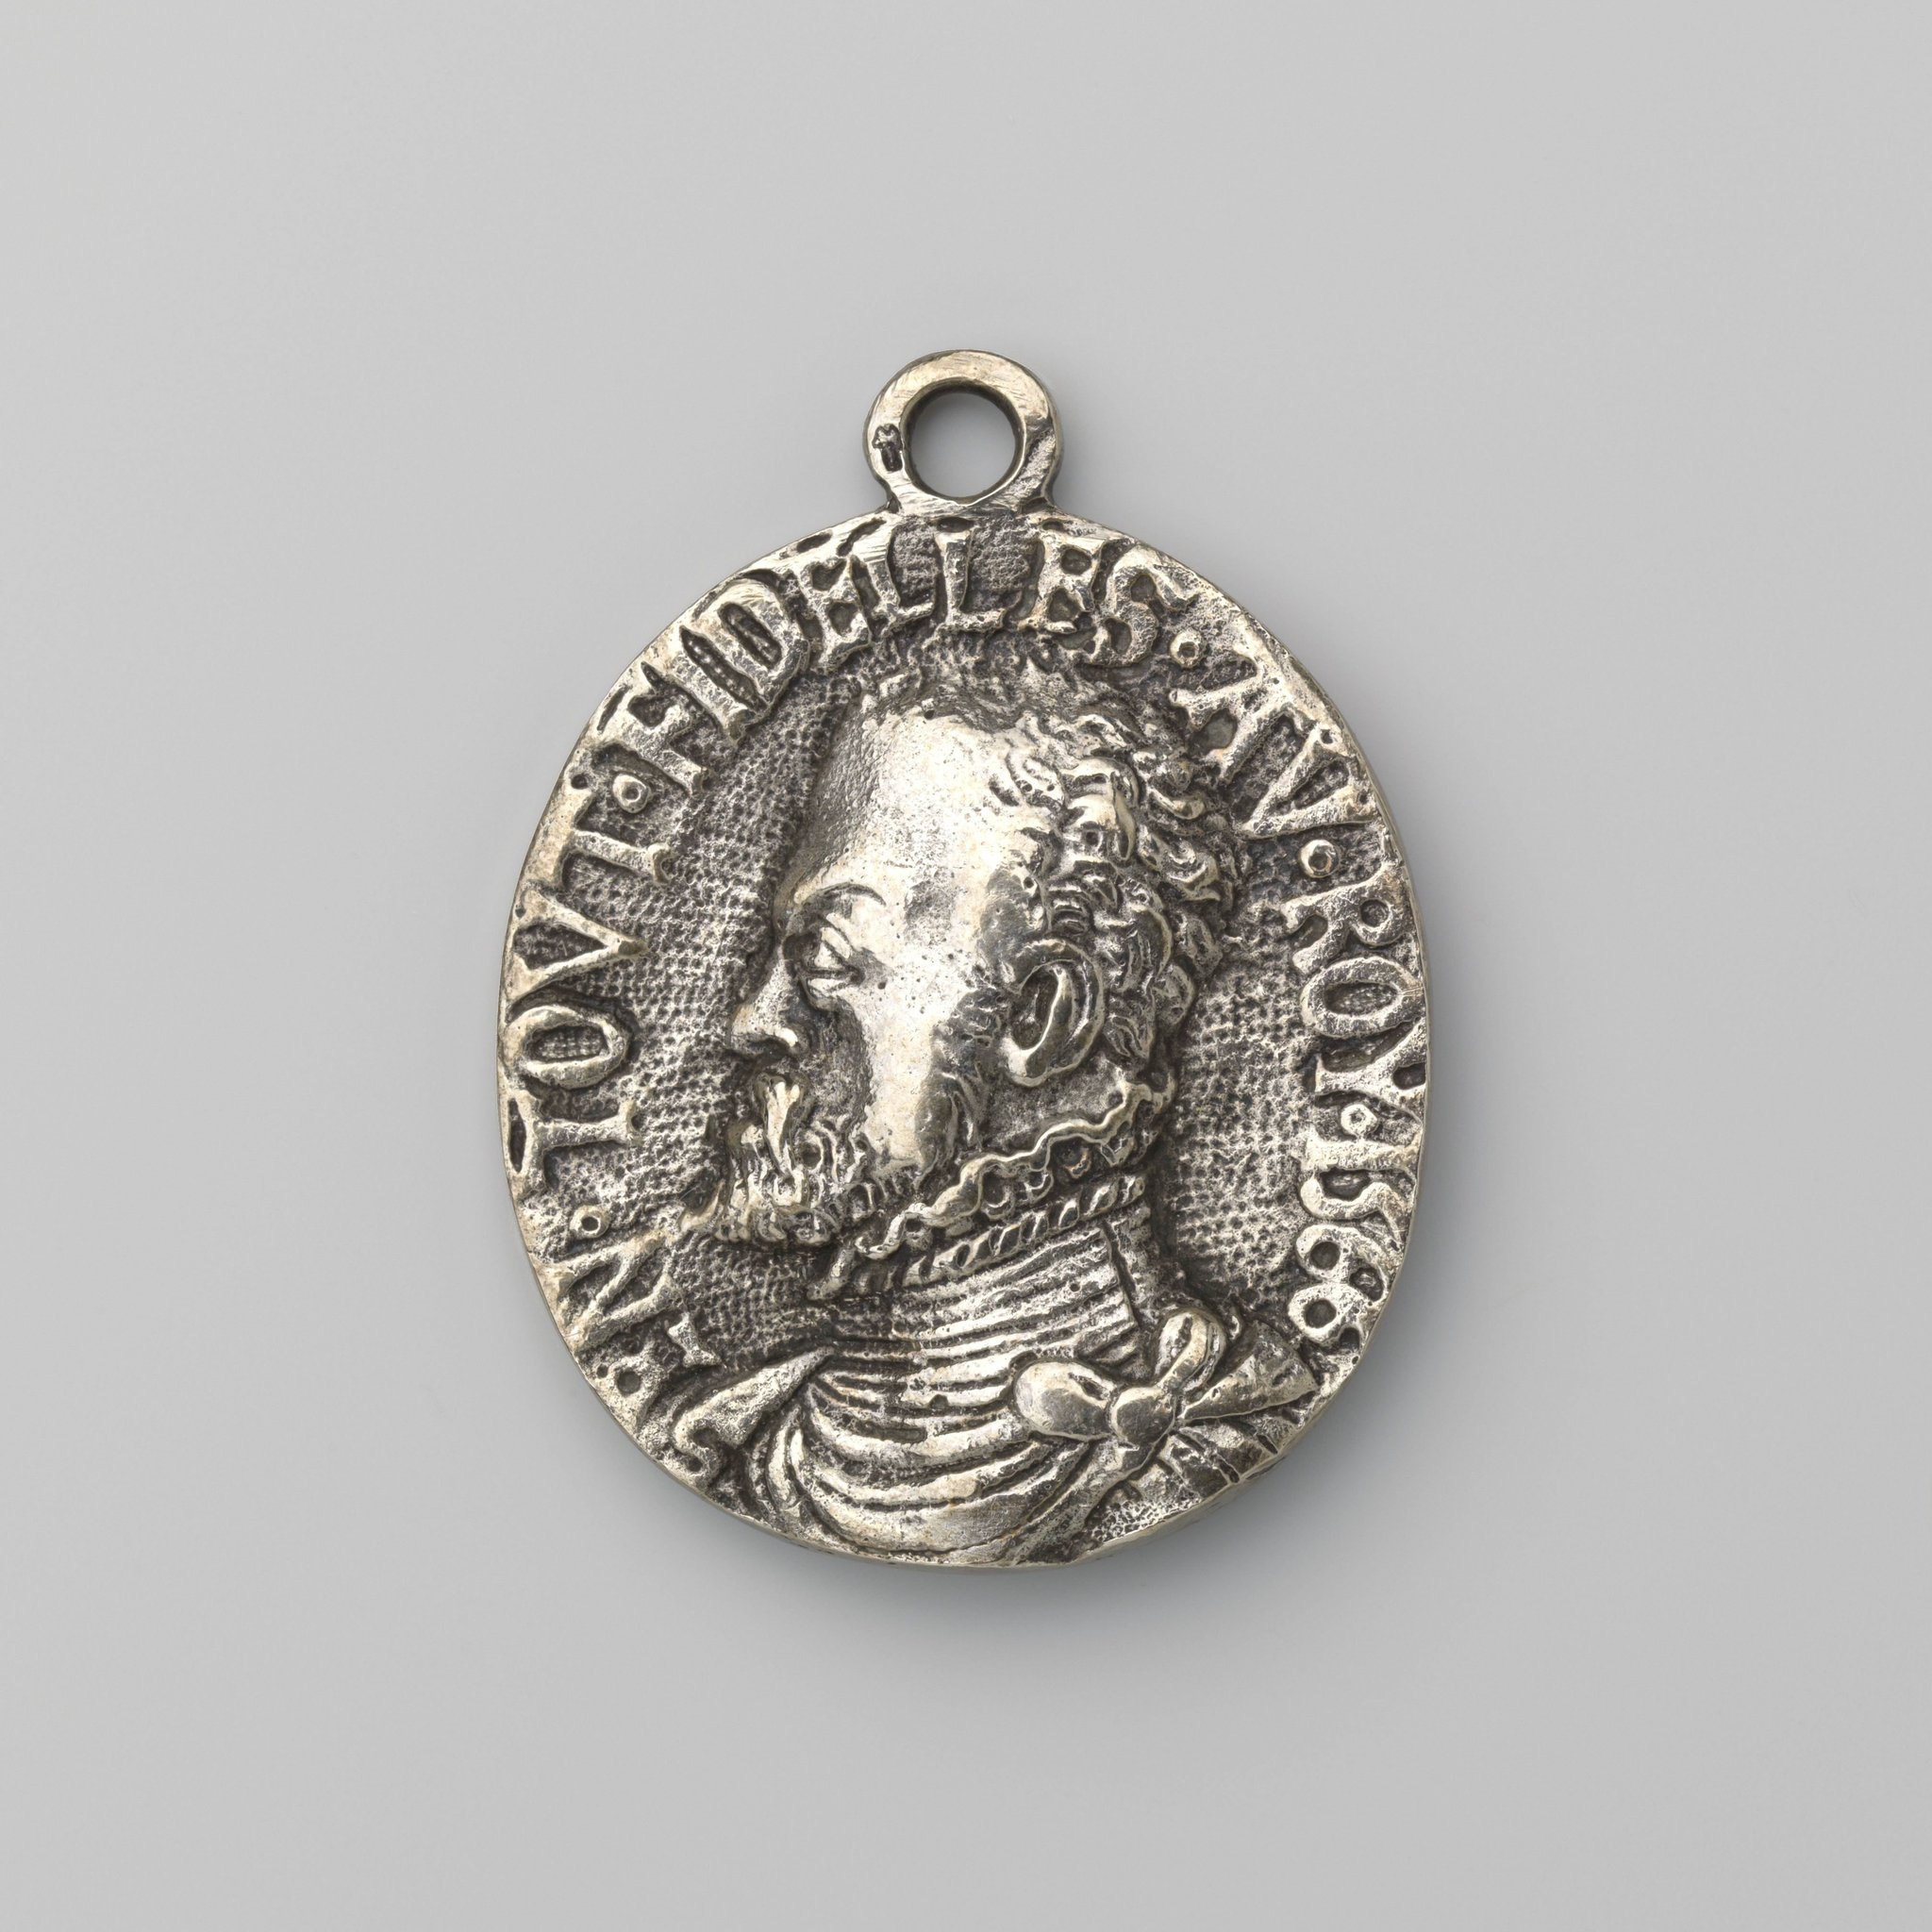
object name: beggar's medal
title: Watergeuzen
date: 1566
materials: silver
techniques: casting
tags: philip ii of spain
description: Zilveren ovale penning met draagoog. Voorzijde: borststuk man binnen omschrift. Keerzijde: twee mannen, waarvan linker bedelnap en kalebas aan riem draagt, geven elkaar hand; tussen hen in opschrift binnen omschrift.